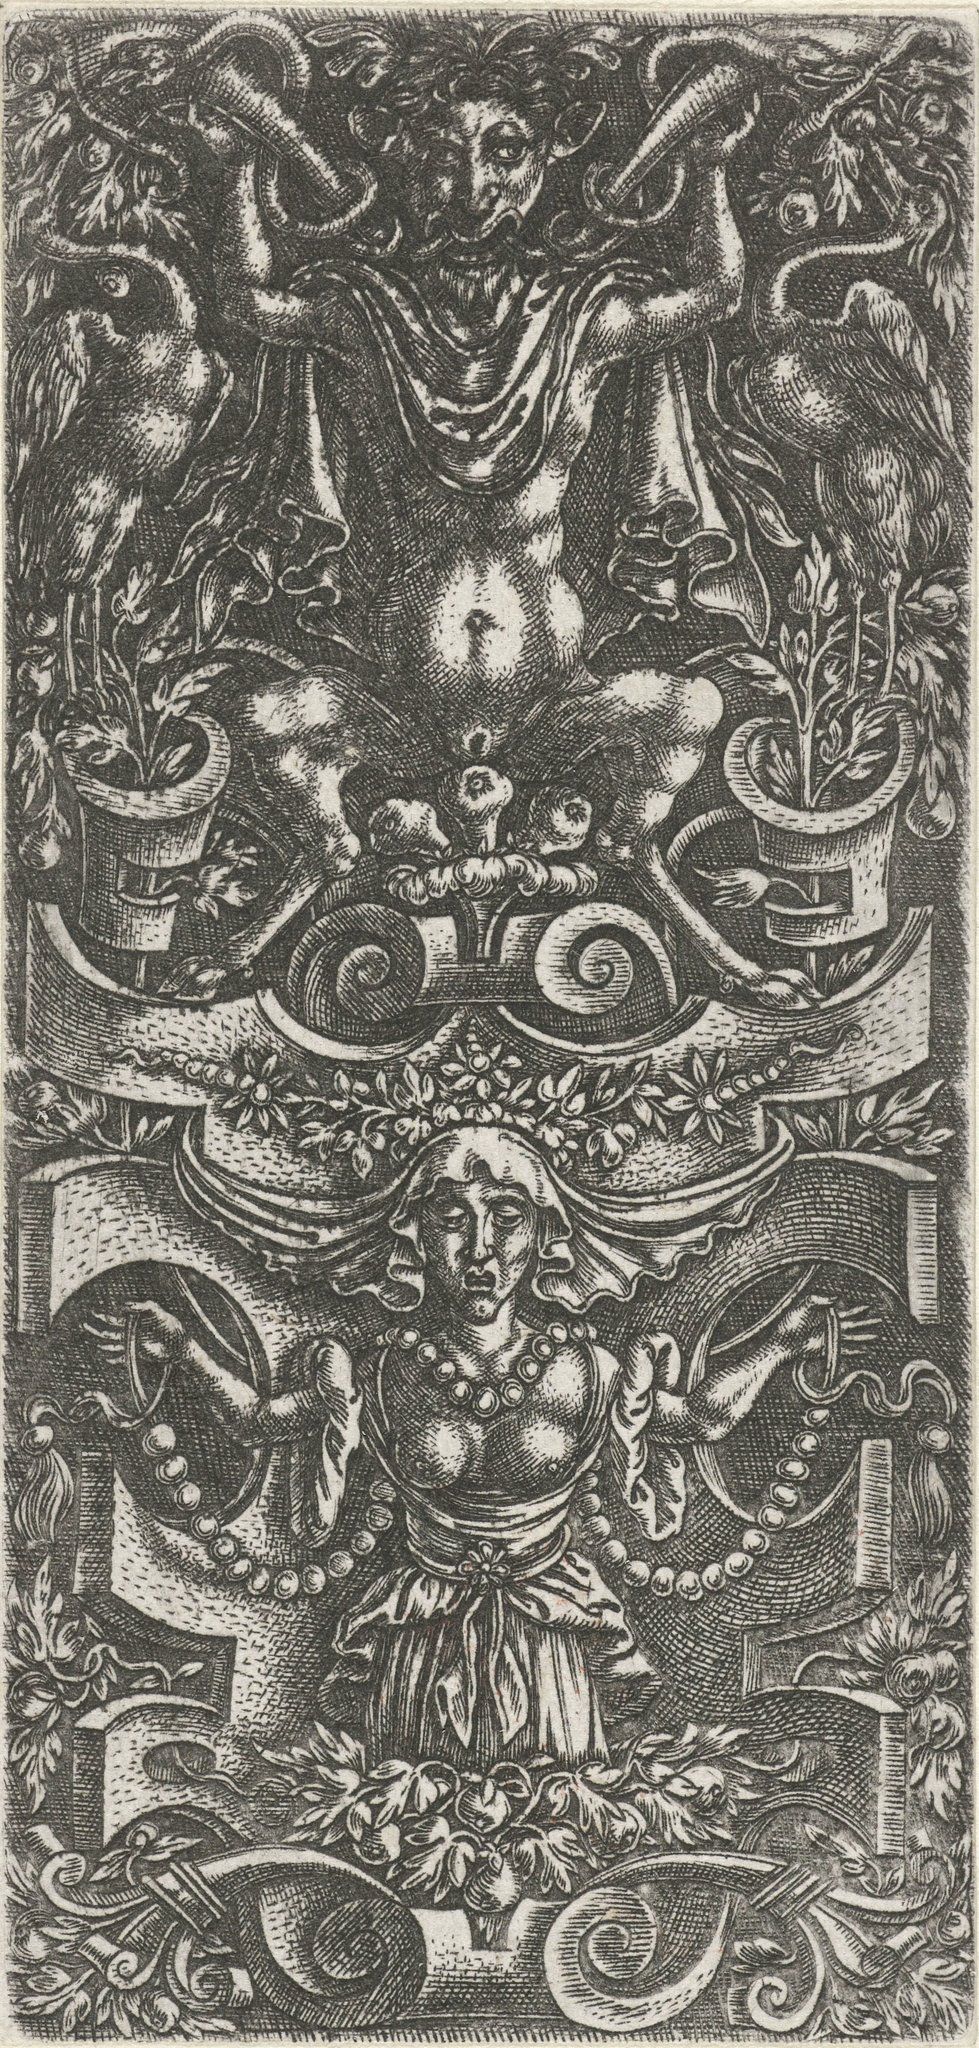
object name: print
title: Vrouw met een hoofddoek en een kralenguirlande voor een constructie van rolwerk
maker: Anonymous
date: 1500-1554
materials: paper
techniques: engraving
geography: germany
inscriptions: collector's mark: Lugt 240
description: Boven de vrouw hurkt een sater die de uiteinden van twee hoorns des overvloeds in zijn mond houdt. Gearceerde achtergrond. Eén van 4 bladen.